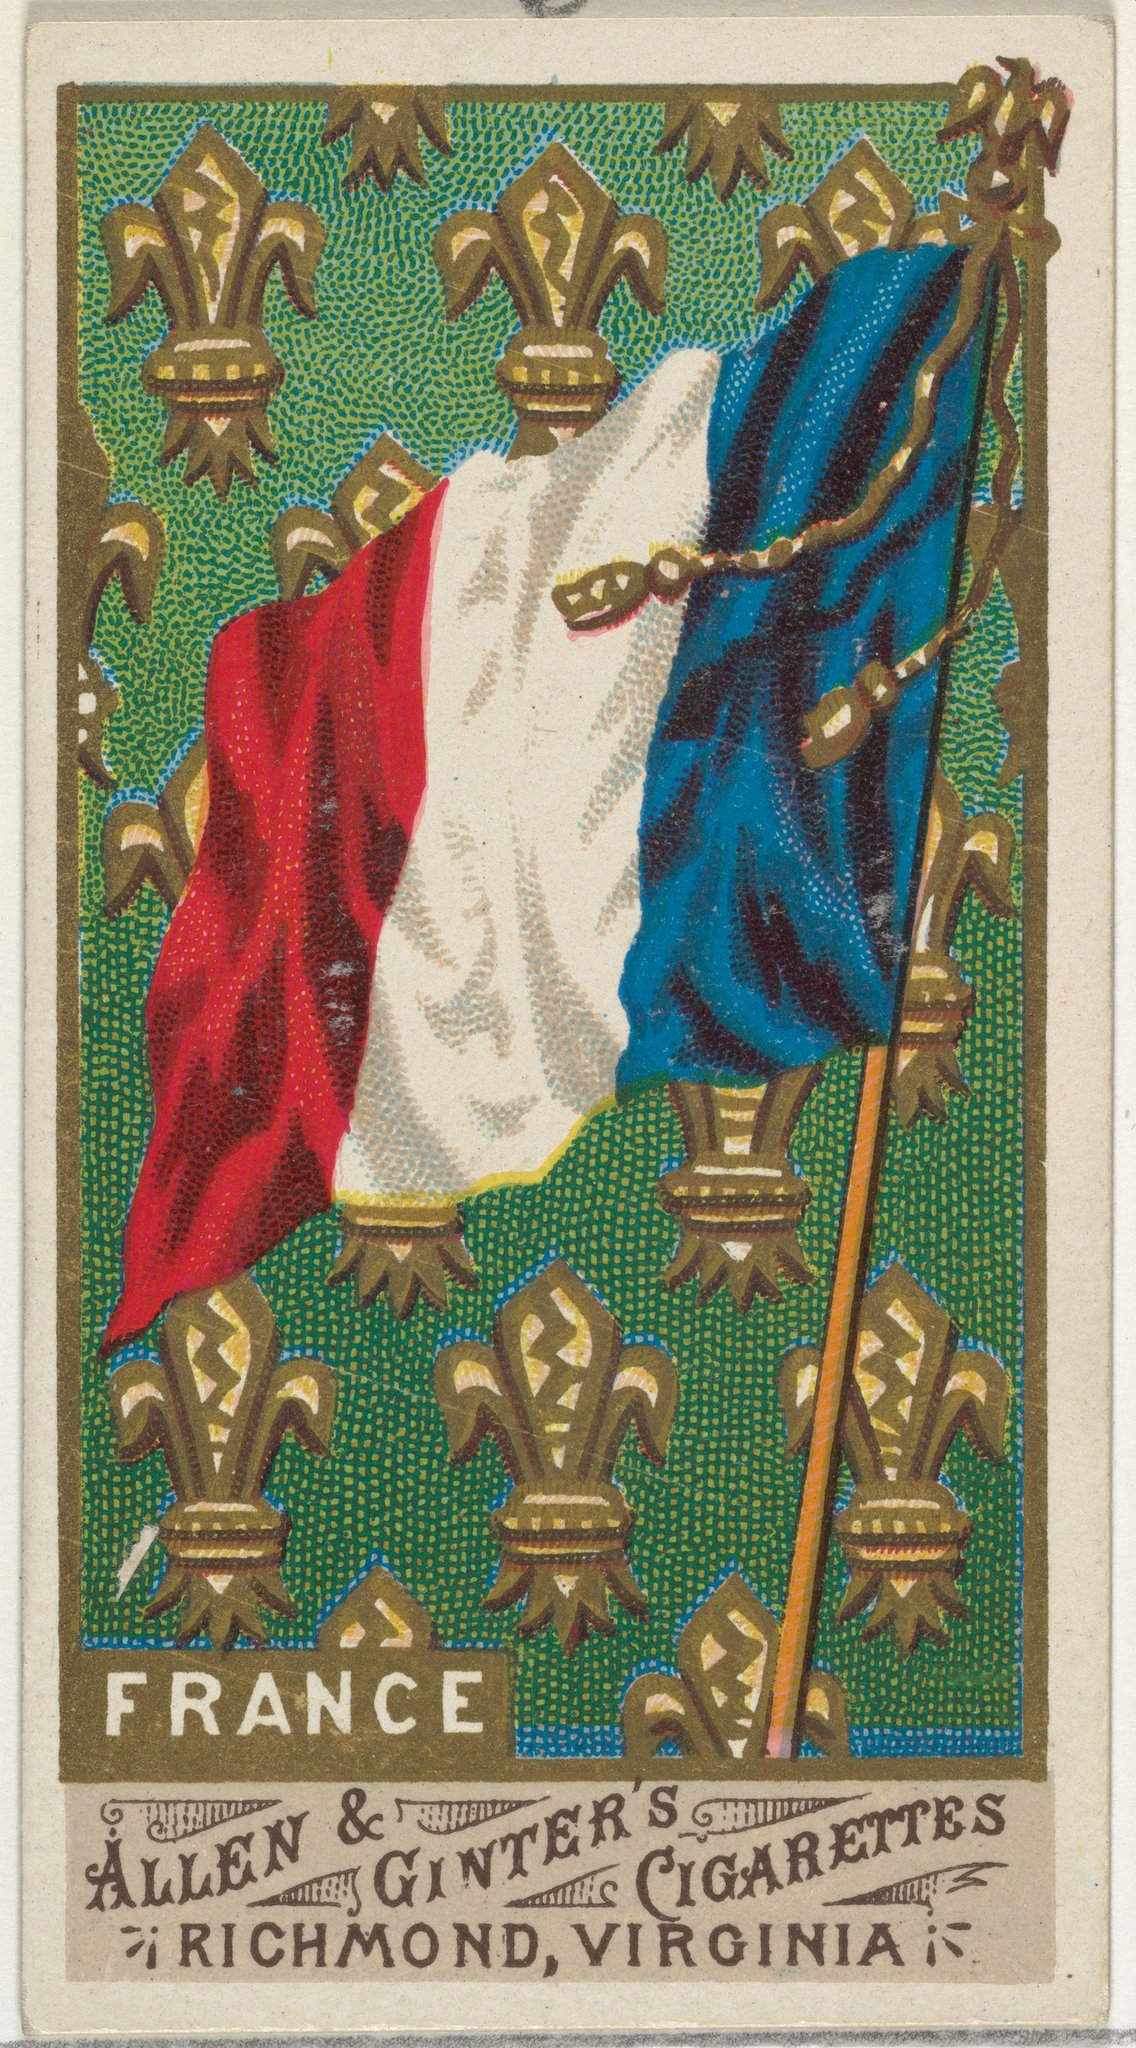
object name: print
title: France, from Flags of All Nations, Series 1 (N9) for Allen & Ginter Cigarettes Brands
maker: allen & ginter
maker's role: publisher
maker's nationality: american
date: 1887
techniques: color lithograph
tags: flags